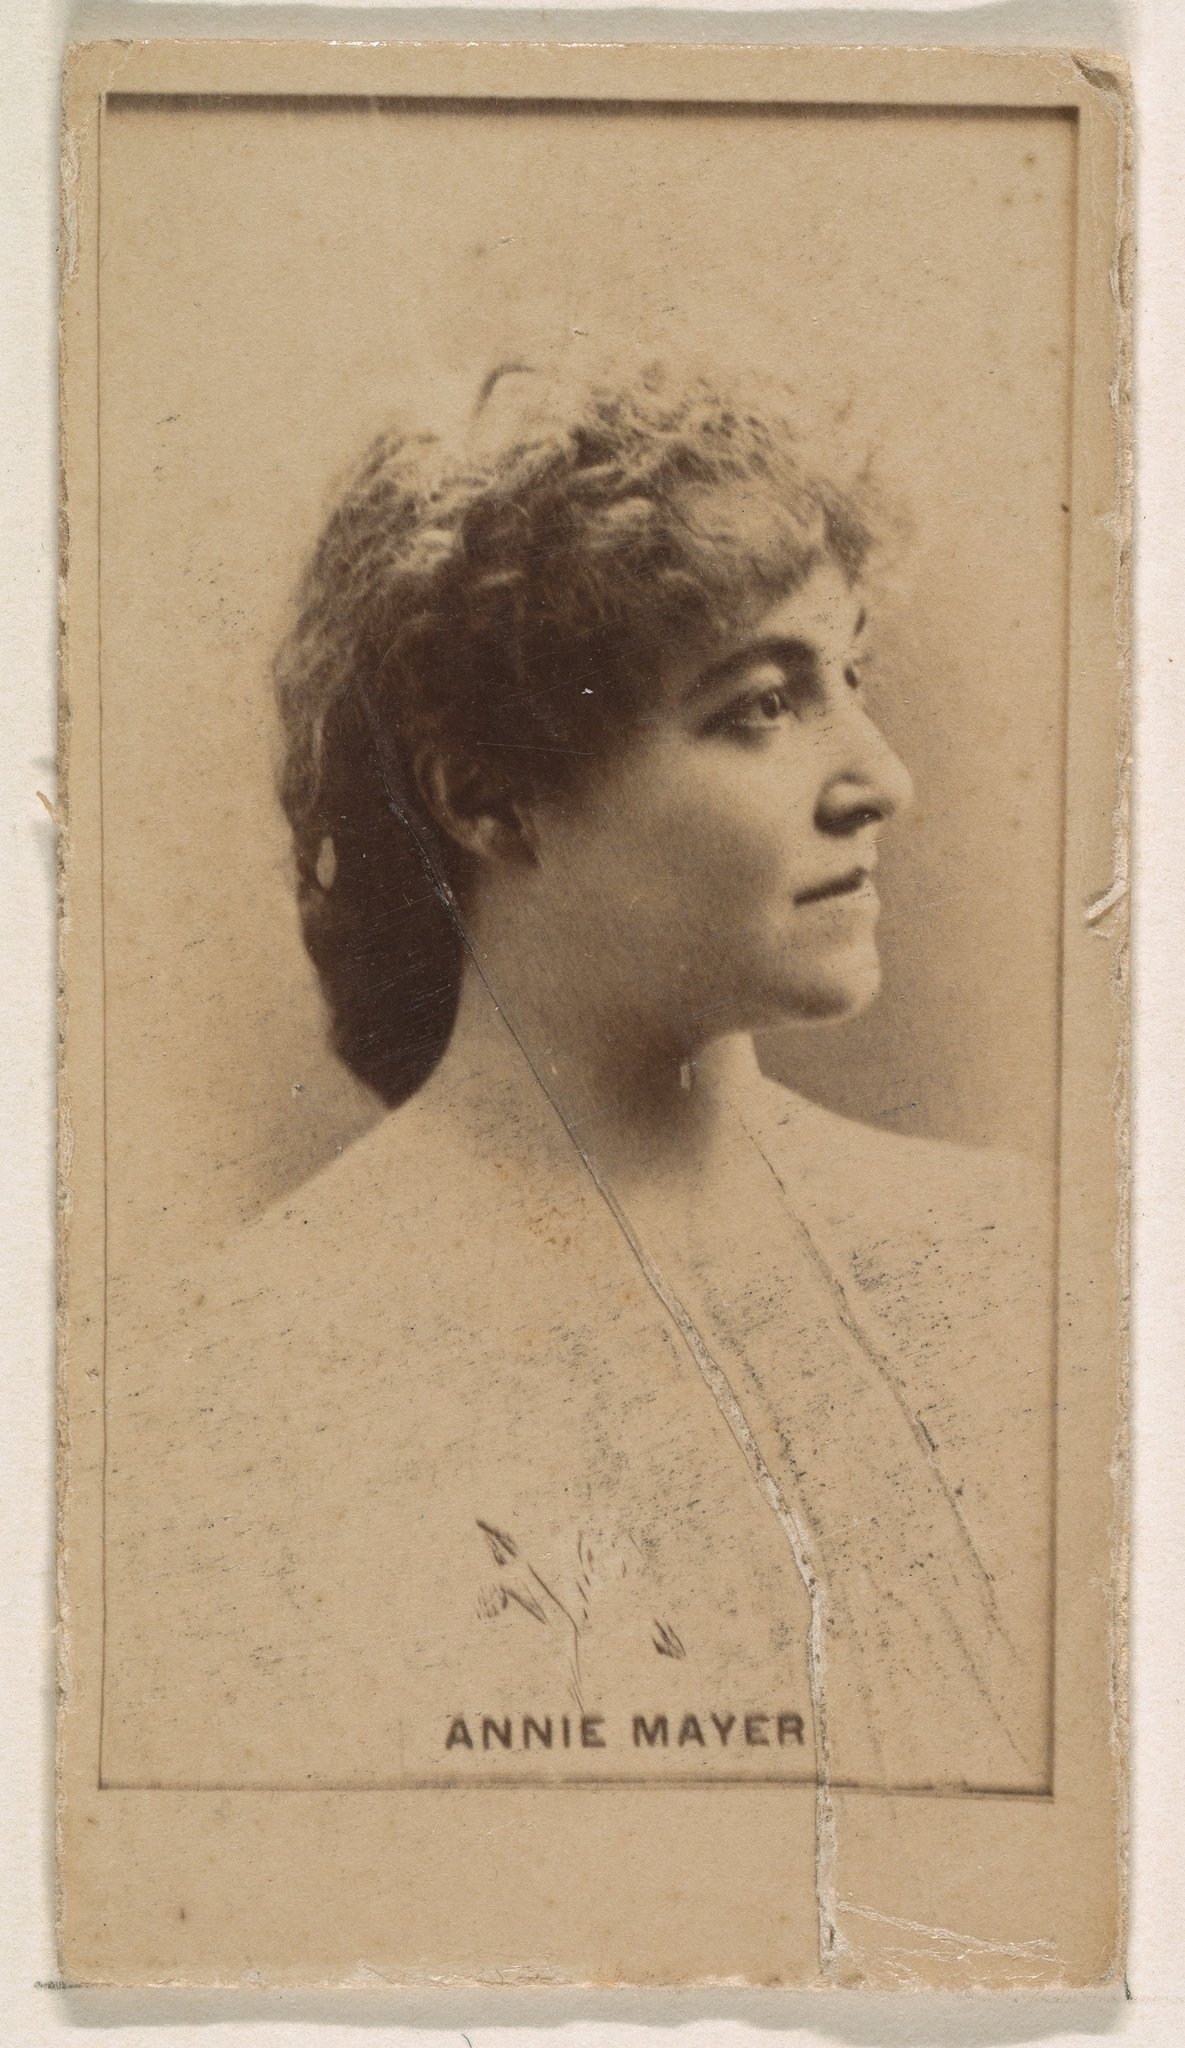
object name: photograph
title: Annie Mayer, from the Actresses series (N245) issued by Kinney Brothers to promote Sweet Caporal Cigarettes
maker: kinney brothers tobacco company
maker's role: publisher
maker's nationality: american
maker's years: 1869-2011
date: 1890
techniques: albumen silver print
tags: portraits,women,actresses